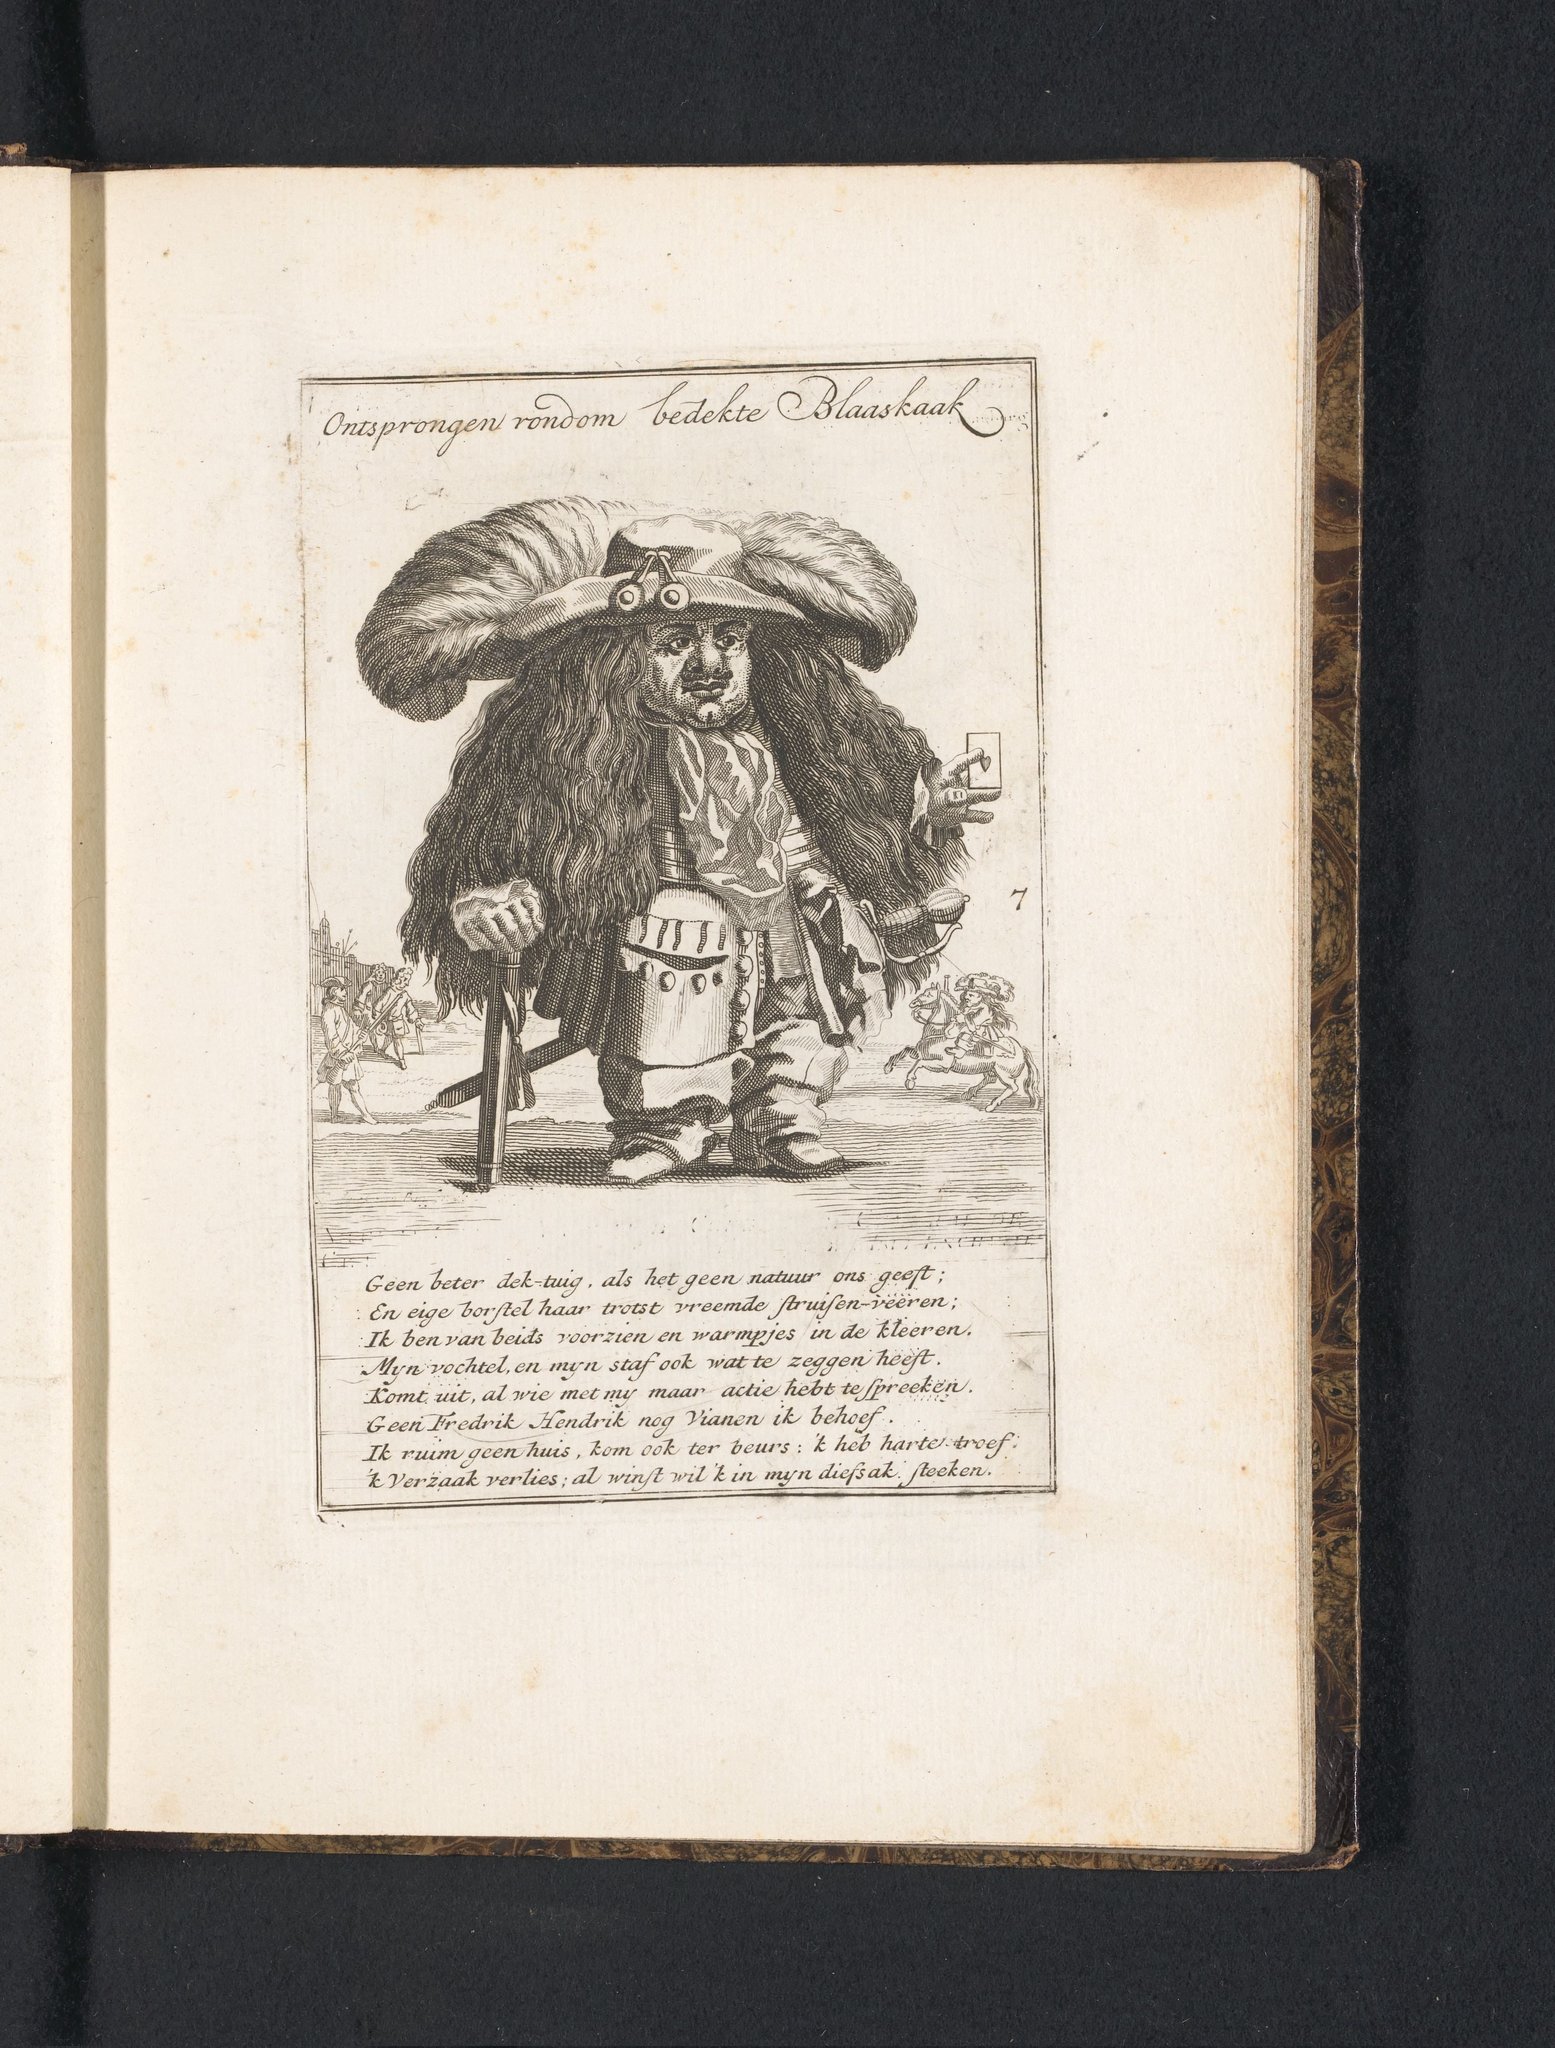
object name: print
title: Bombario Actionist en de Geest van Esopus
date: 1718-1720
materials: paper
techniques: etching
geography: northern netherlands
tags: caricatures (human types), little people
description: Een kleine mens als officier met grote verenhoed en een speelkaart in de hand. In het onderschrift een vers in het Nederlands. Genummerd rechts midden: 7. Onderdeel van de tweede Nederlandse gebonden uitgave uit 1720 (en gerelateerd aan de Windhandel in dat jaar) van een serie karikaturen van kleine mensen, bekend als Het Dwergentooneel.